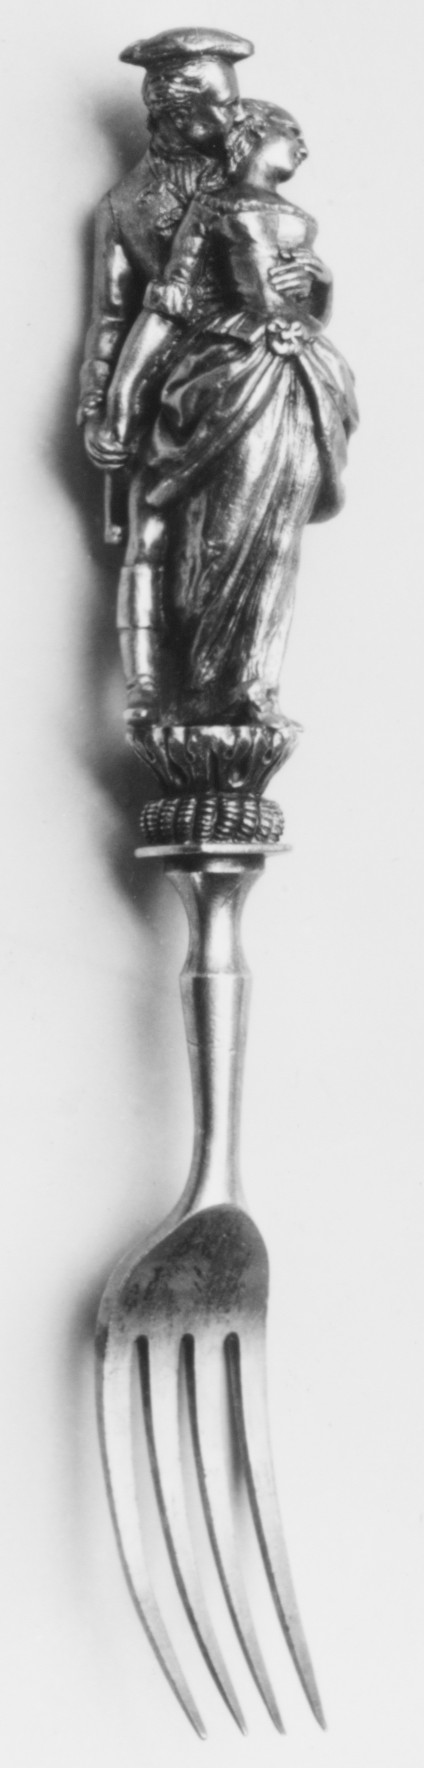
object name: fork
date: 1801-1900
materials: silver gilt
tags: men,women